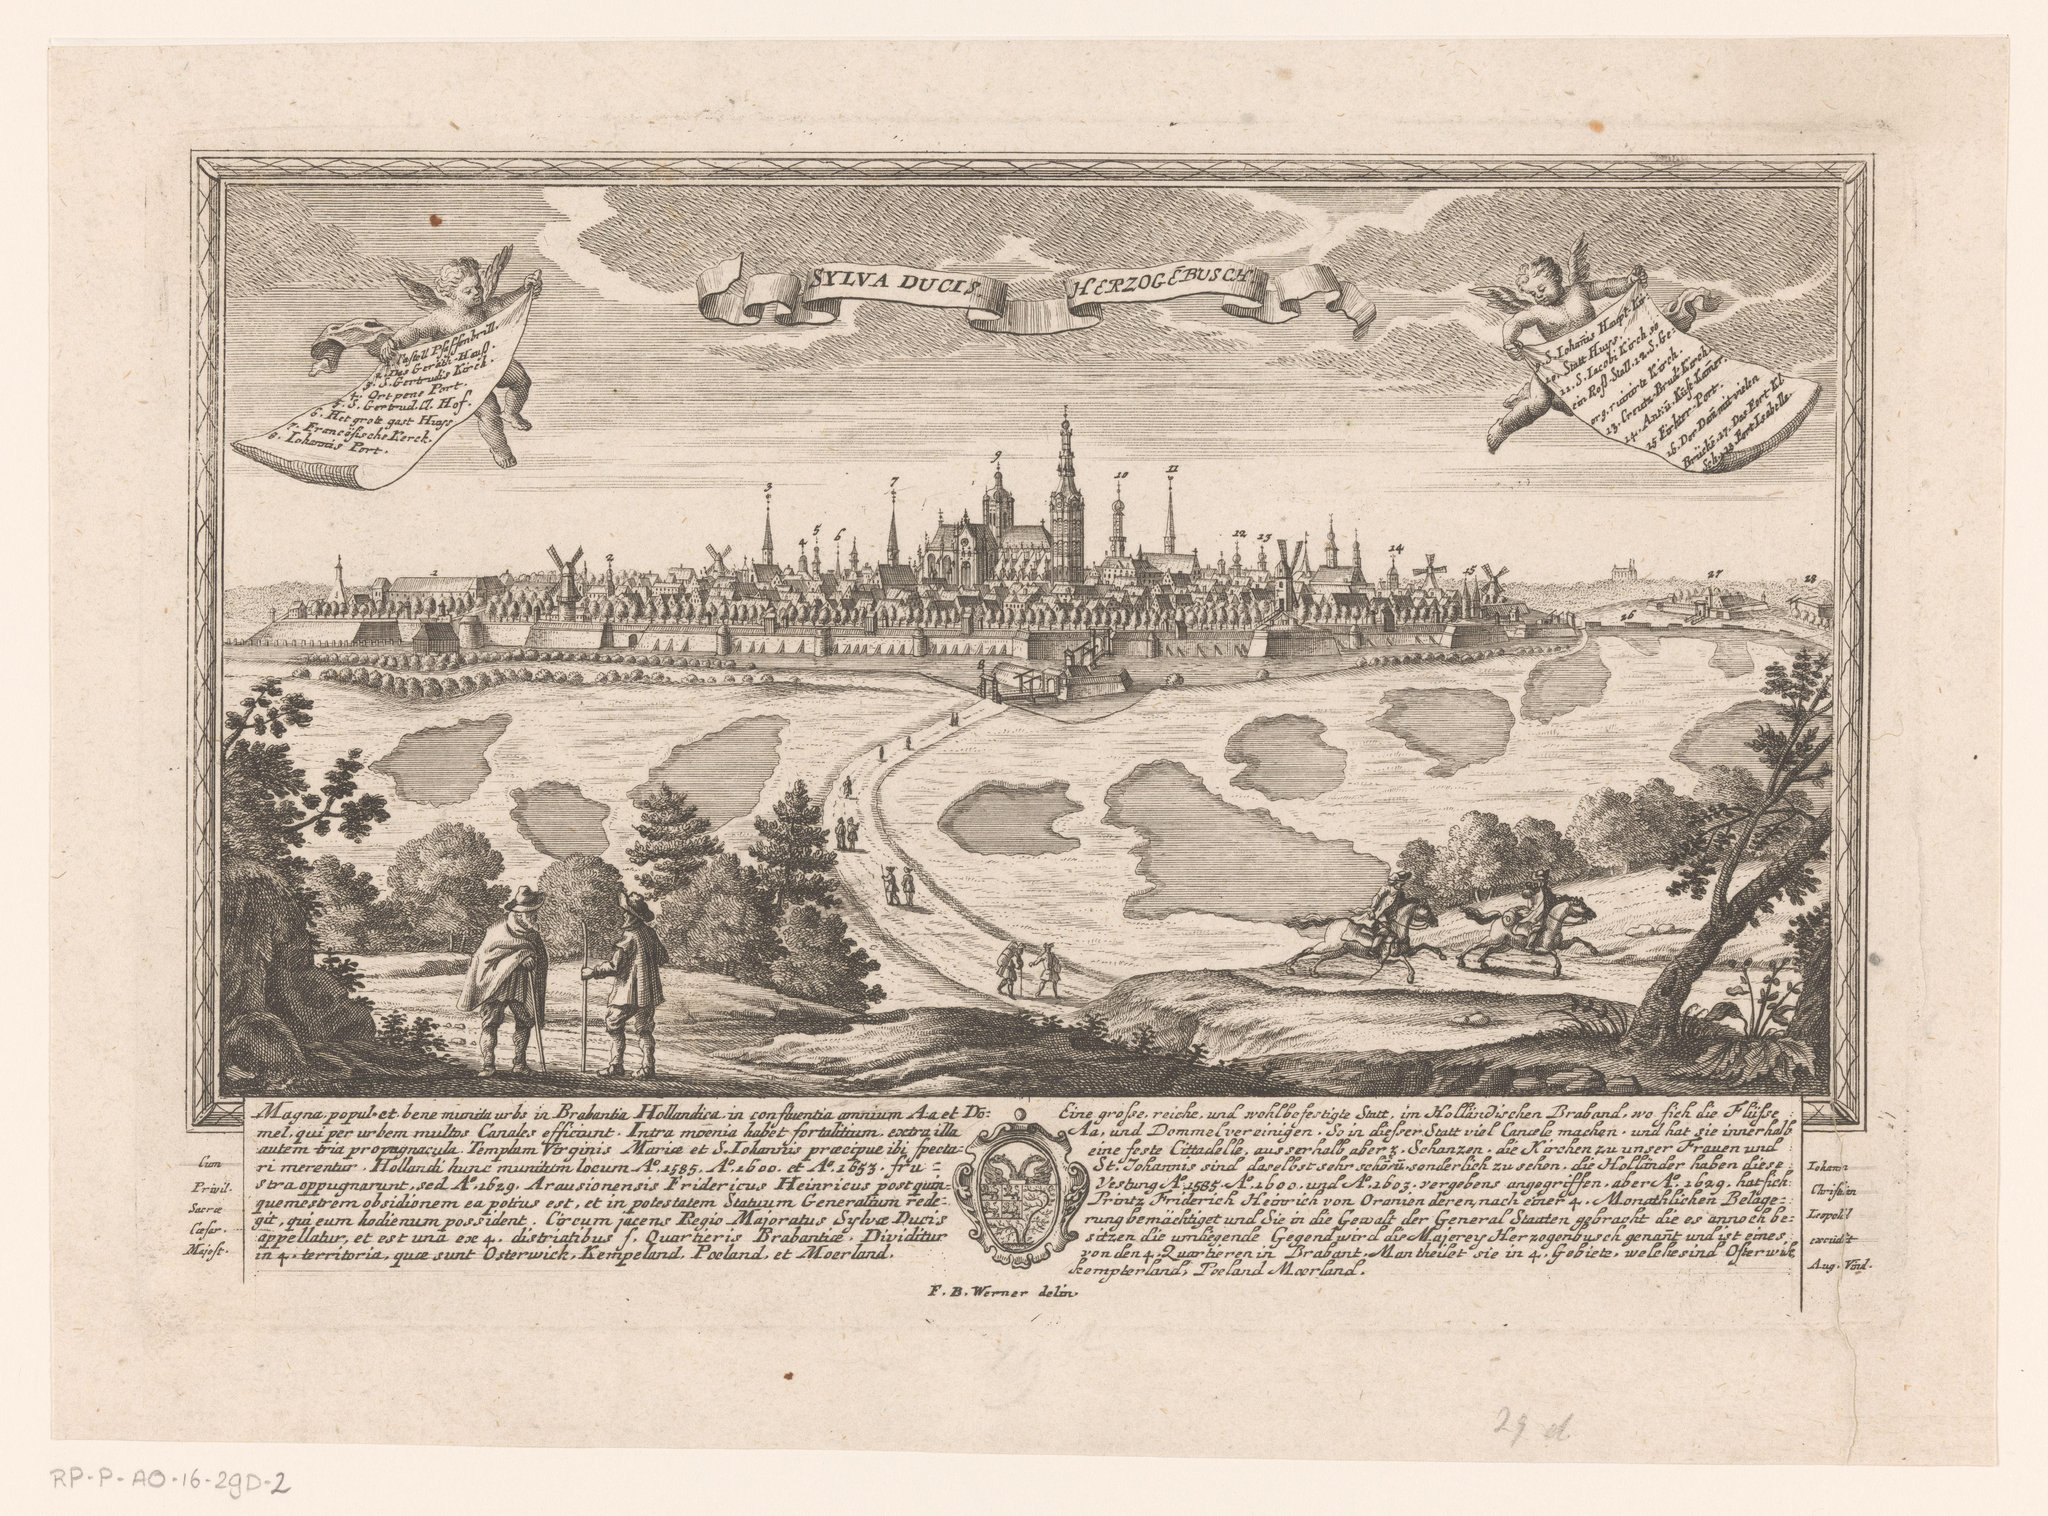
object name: print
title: Sylva Duces. Herzogebusch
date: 1709-1755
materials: paper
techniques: engraving, etching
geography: augsburg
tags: coat of arms (as symbol of the state, etc.) (+ city; municipal), prospect of city, town panorama, silhouette of city, den bosch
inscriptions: collector's mark: Lugt 2228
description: Gezicht op 's-Hertogenbosch. Boven in het midden de titel. Linksboven een putto met een banderol met daarop een Duitse legenda 1-8, rechtsboven nog een putto met een banderol met daarop een Duitse legenda 9-18. Onder de voorstelling een tekst met informatie over de stad in het Latijn (links) en het Duits (rechts). Tussen de Duitse en Latijnse tekst het wapen van de stad 's-Hertogenbosch.